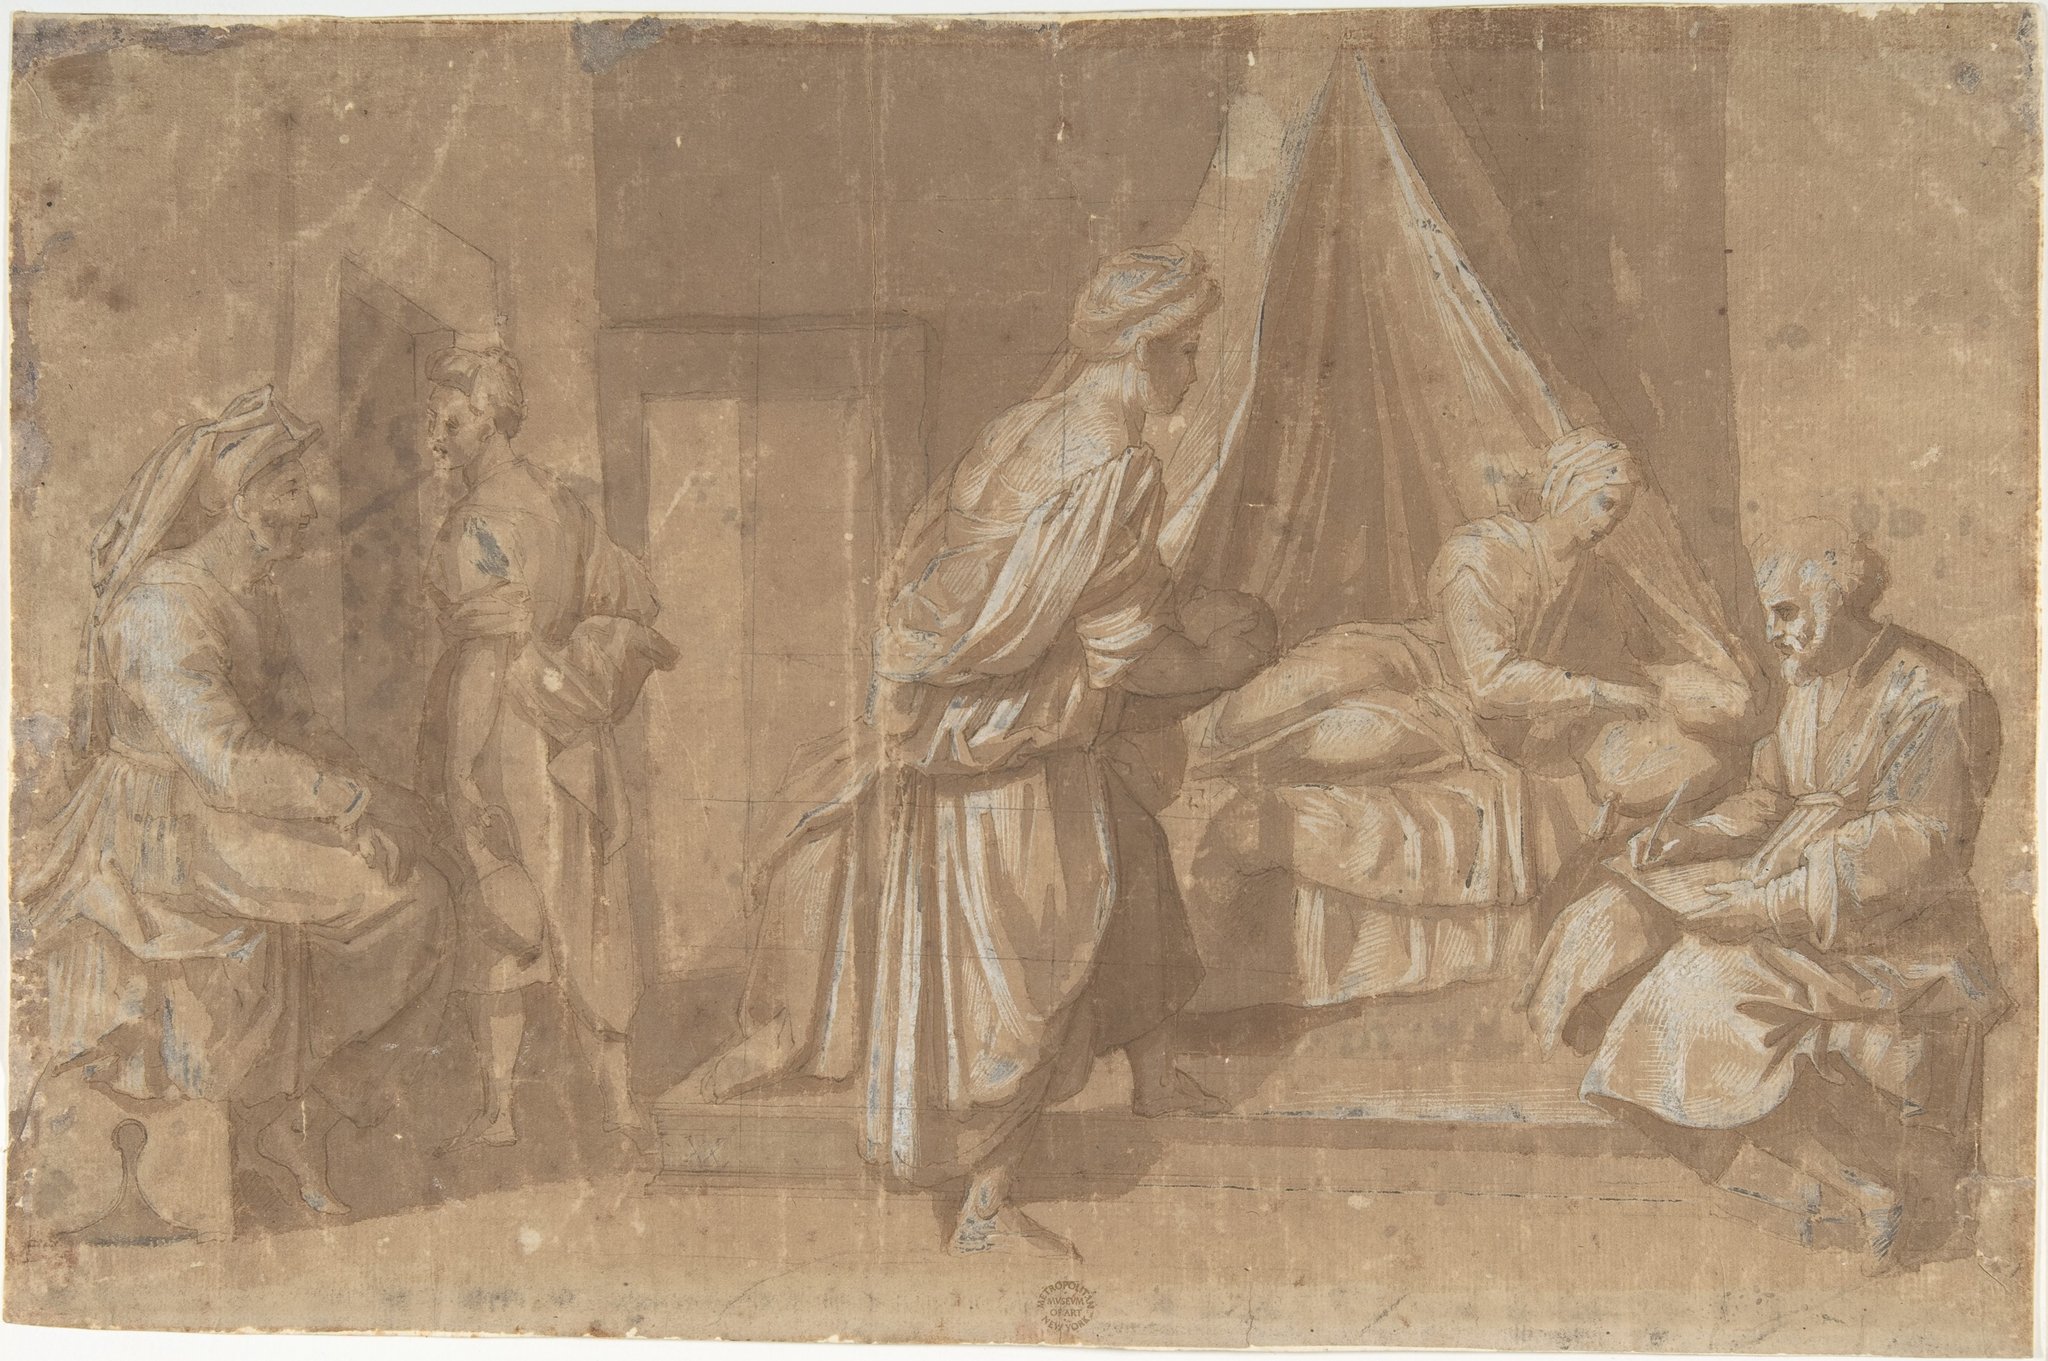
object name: drawing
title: The Birth of Saint John the Baptist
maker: andrea del sarto (andrea d'agnolo)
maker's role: artist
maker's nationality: italian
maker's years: 1486-1530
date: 1501-1600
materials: ink, paper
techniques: brush, highlighting, pen, wash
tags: men,women,saint john the baptist,beds